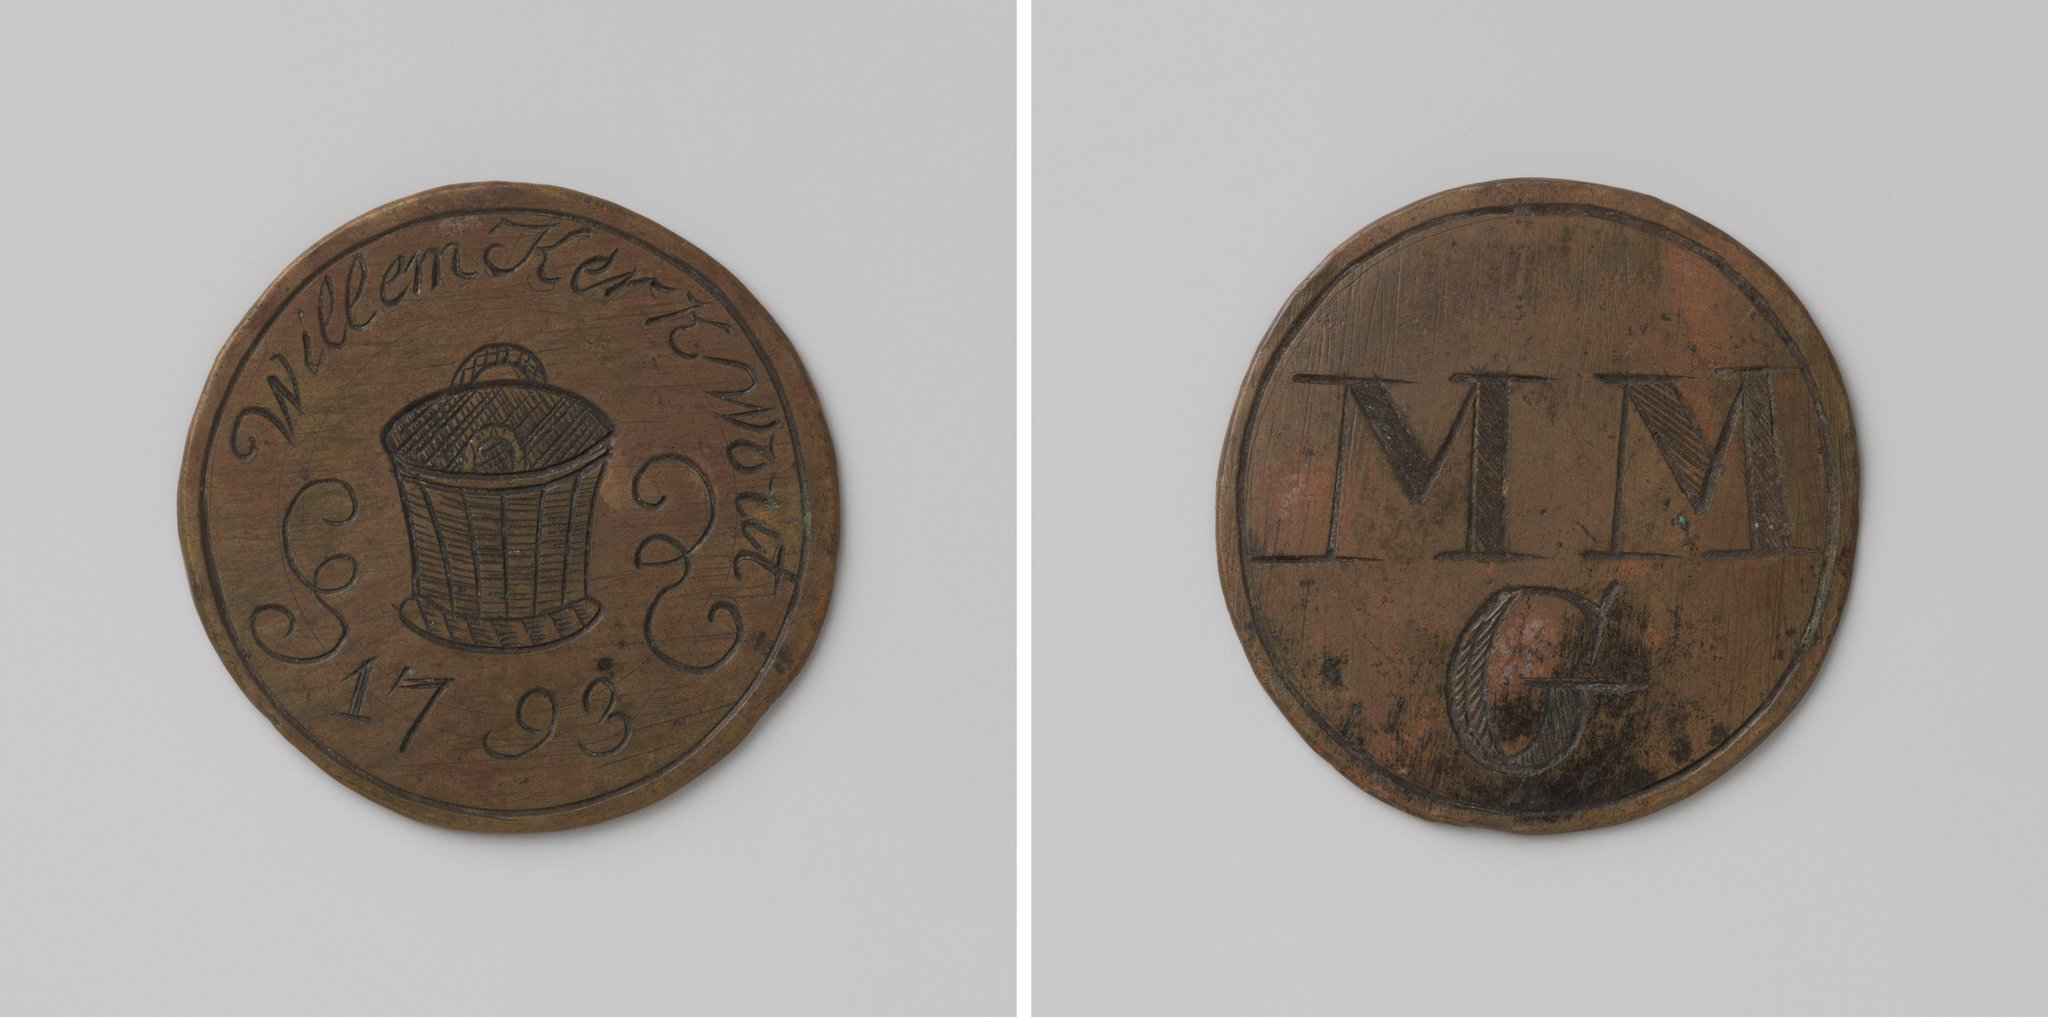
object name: medal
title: Mandemakersgilde van Amsterdam, gildepenning van Willem Kerkwout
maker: Anonymous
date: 1793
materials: brass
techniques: engraving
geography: amsterdam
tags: amsterdam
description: Messing penning. Voorzijde: mand tussen twee krullen boven jaartal binnen omschrift. Keerzijde: twee letters M boven letter G